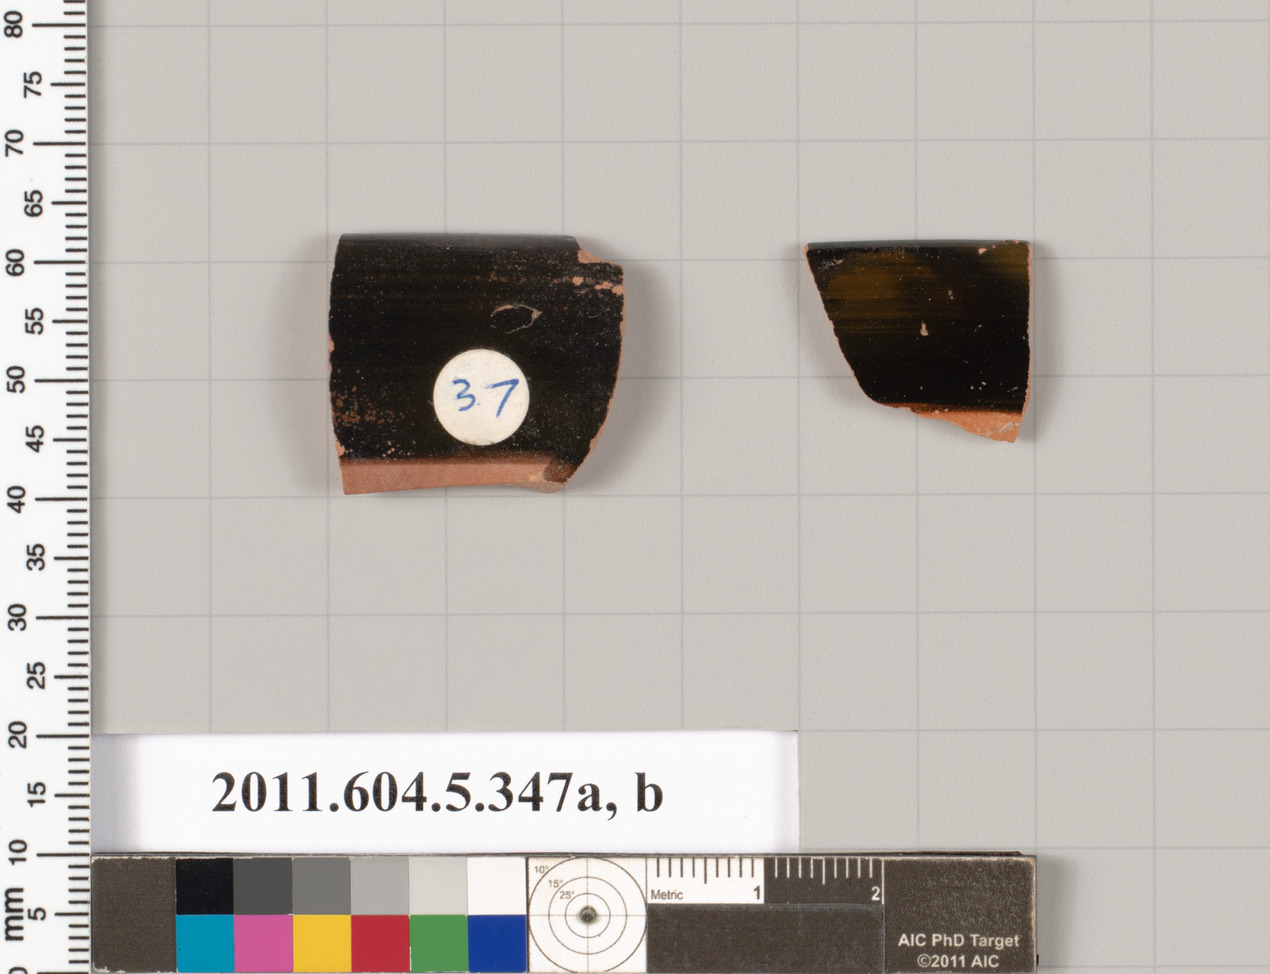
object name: kylix fragment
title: Terracotta rim fragments of kylikes (drinking cups)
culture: greek, attic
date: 600-401 BCE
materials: terracotta